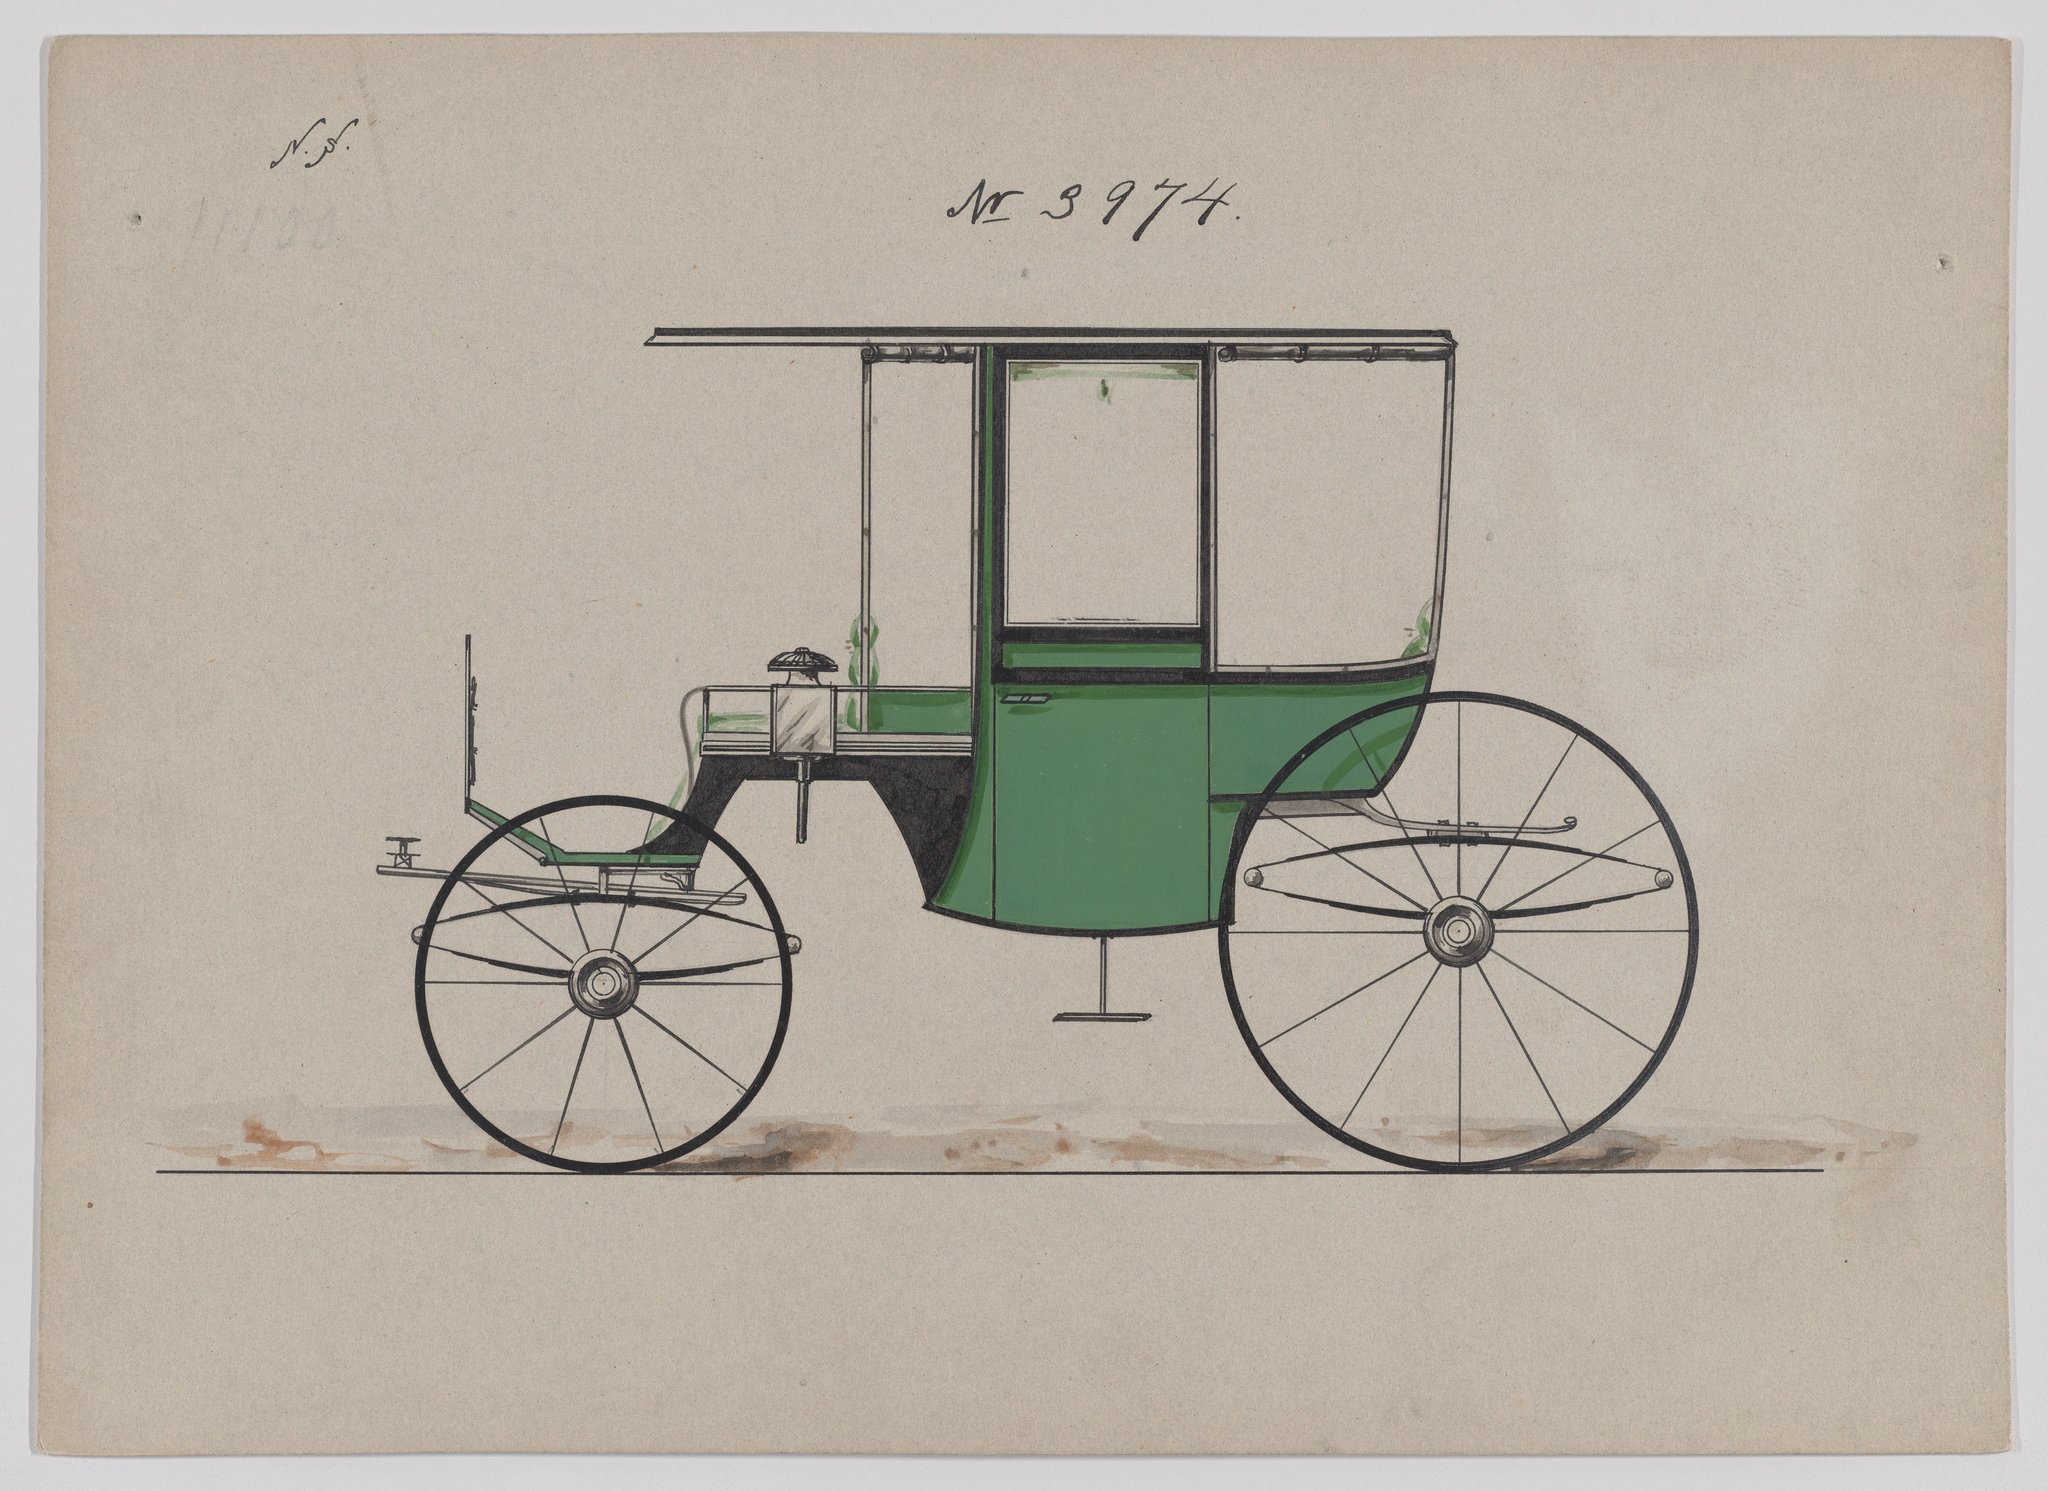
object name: drawing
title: Design for 6 seat Rockaway, no. 3974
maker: brewster & co.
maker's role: manufacturer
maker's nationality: american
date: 1886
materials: gouache, ink, watercolor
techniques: pen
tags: carriages